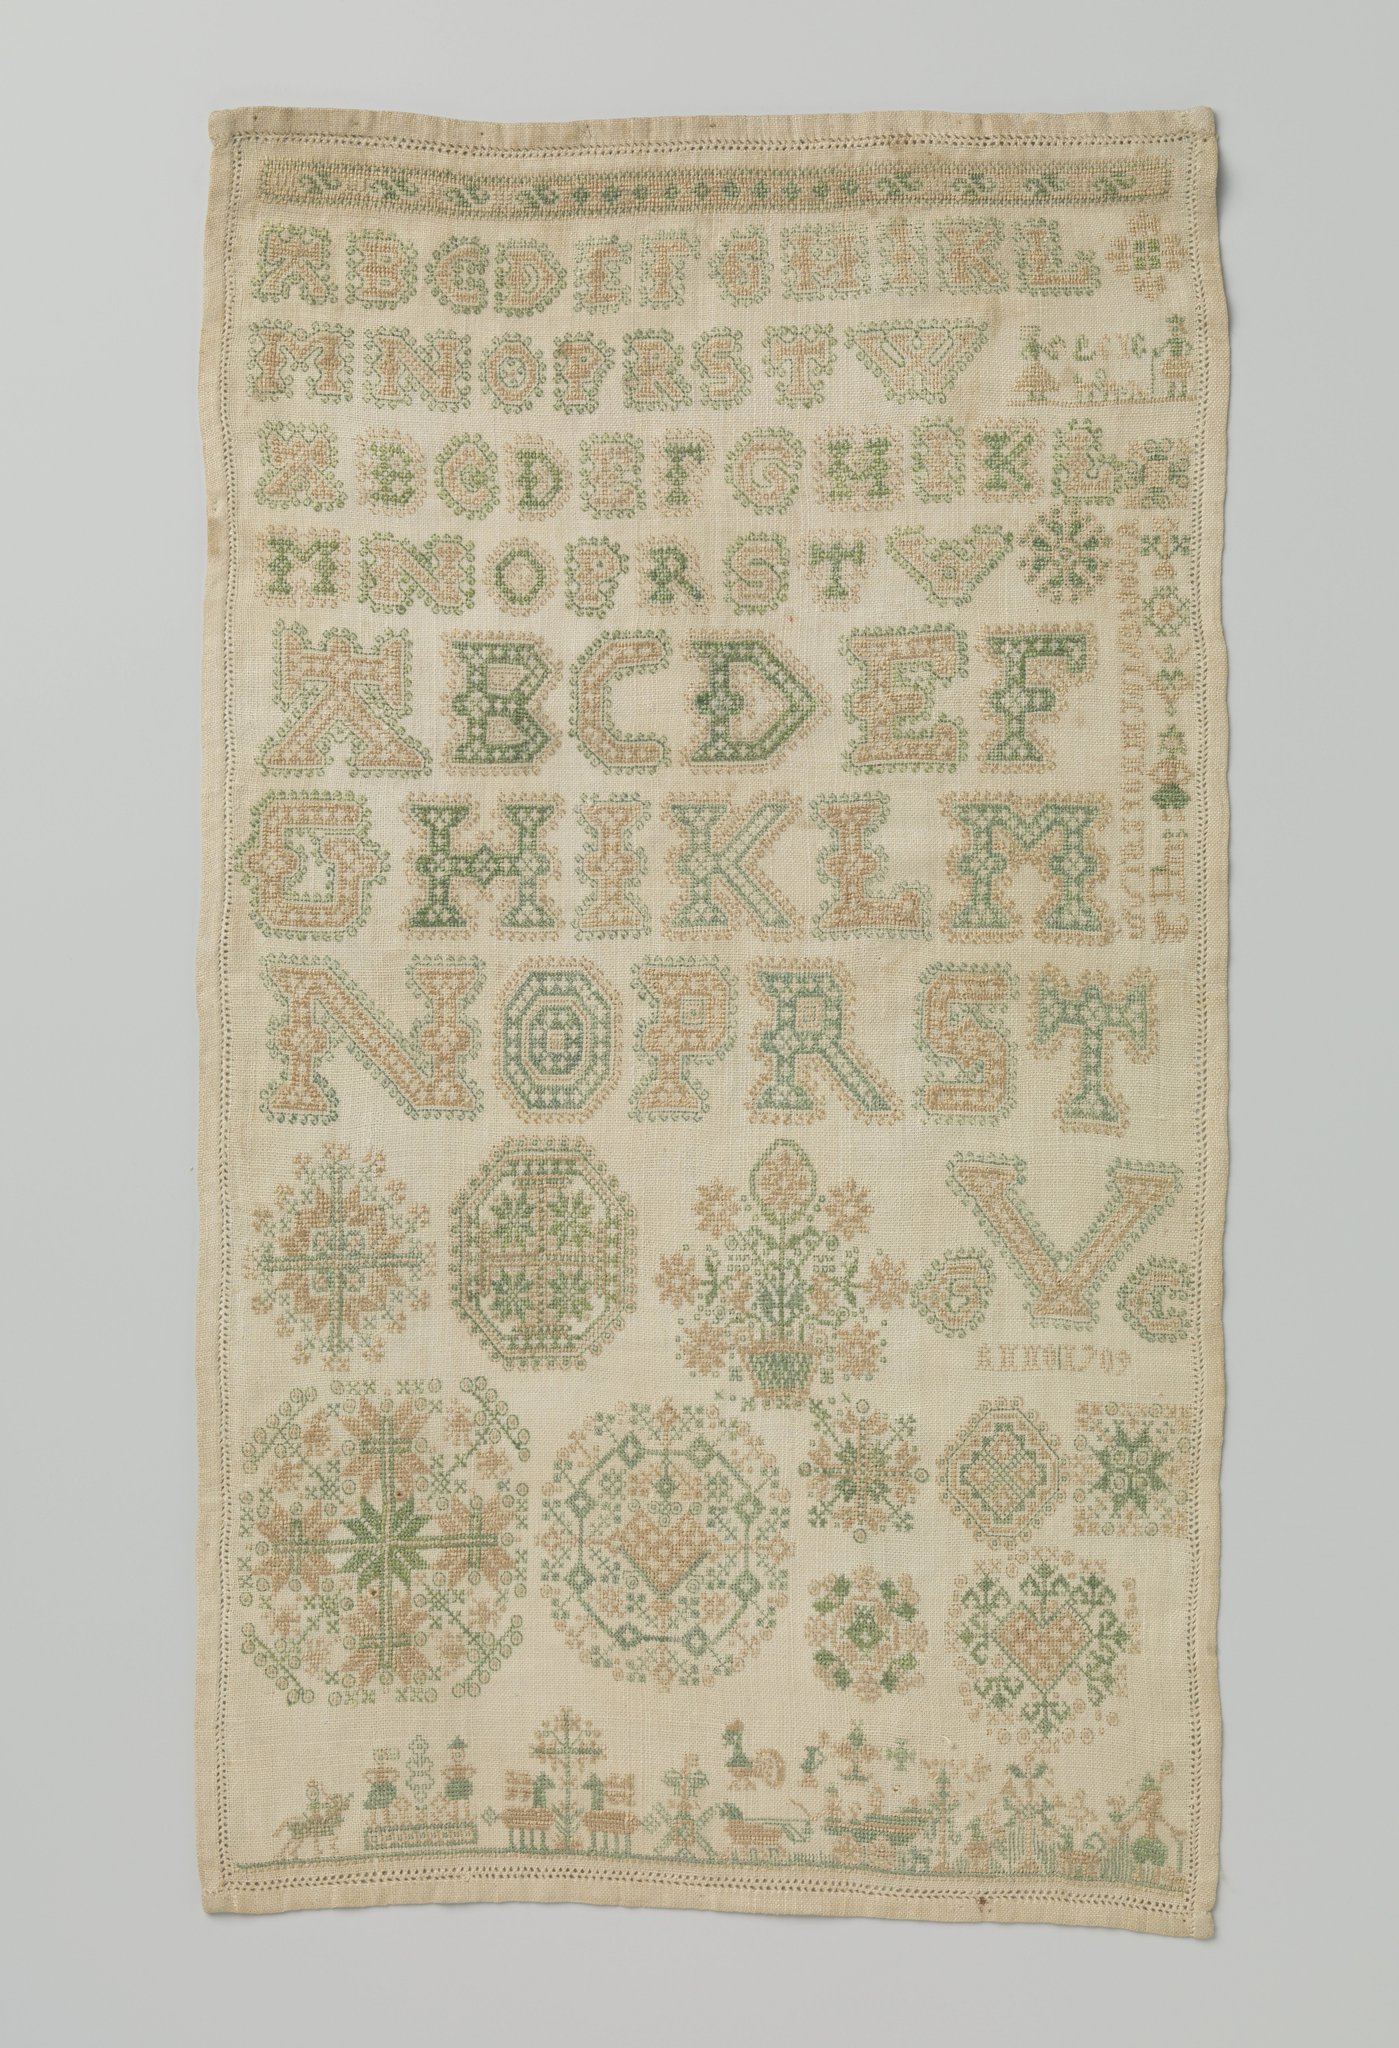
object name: merkdoek, merklap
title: Merklap met borduurwerk. Het borduurwerk heeft de initialen GCIC, het jaartal 1709, driemaal het alfabet en diverse figuren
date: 1709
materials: linen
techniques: embroidered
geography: friesland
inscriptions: date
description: Merklap met borduurwerk. Het borduurwerk heeft de initialen GCIC, het jaartal 1709, driemaal het alfabet en diverse figuren. Langs de onderrand zijn paarden, honden, man- en vrouwfiguren en een molen geborduurd.